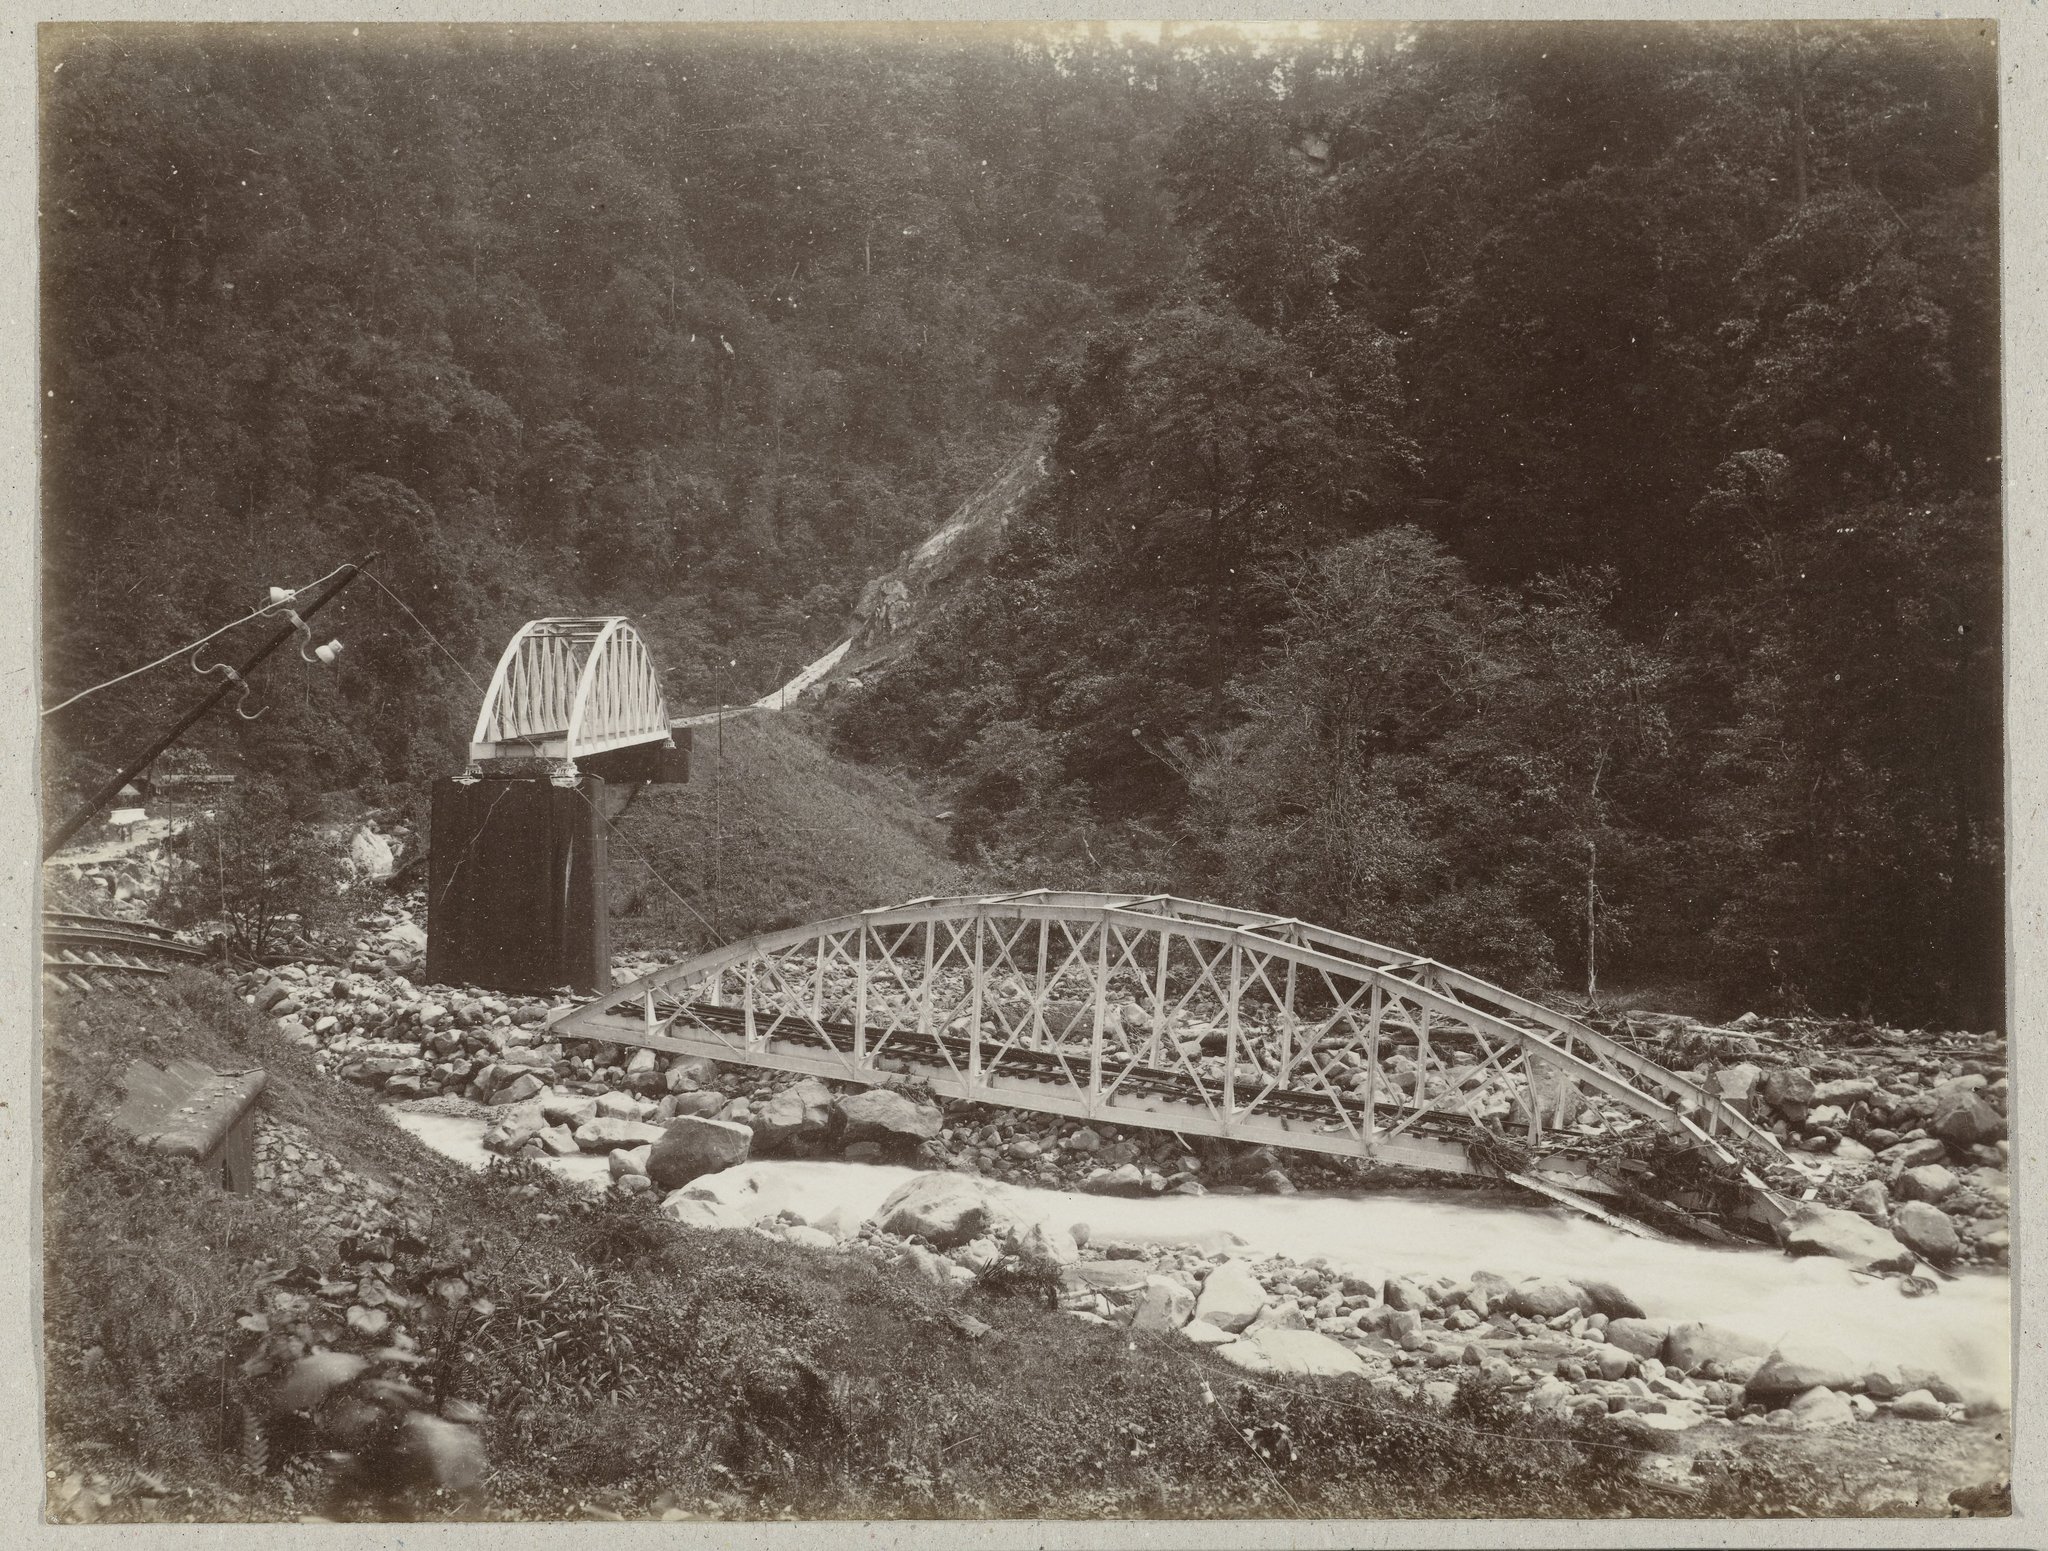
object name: photograph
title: Ingestorte spoorbrug in de Anaikloof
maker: christiaan benjamin nieuwenhuis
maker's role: publisher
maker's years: 1863-1922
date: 1892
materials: paper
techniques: albumen print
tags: funicular railway, landscape with bridge, viaduct or aqueduct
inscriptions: inscription: ‘Verwoesting in de Anei Kloof 5 Dec '92’